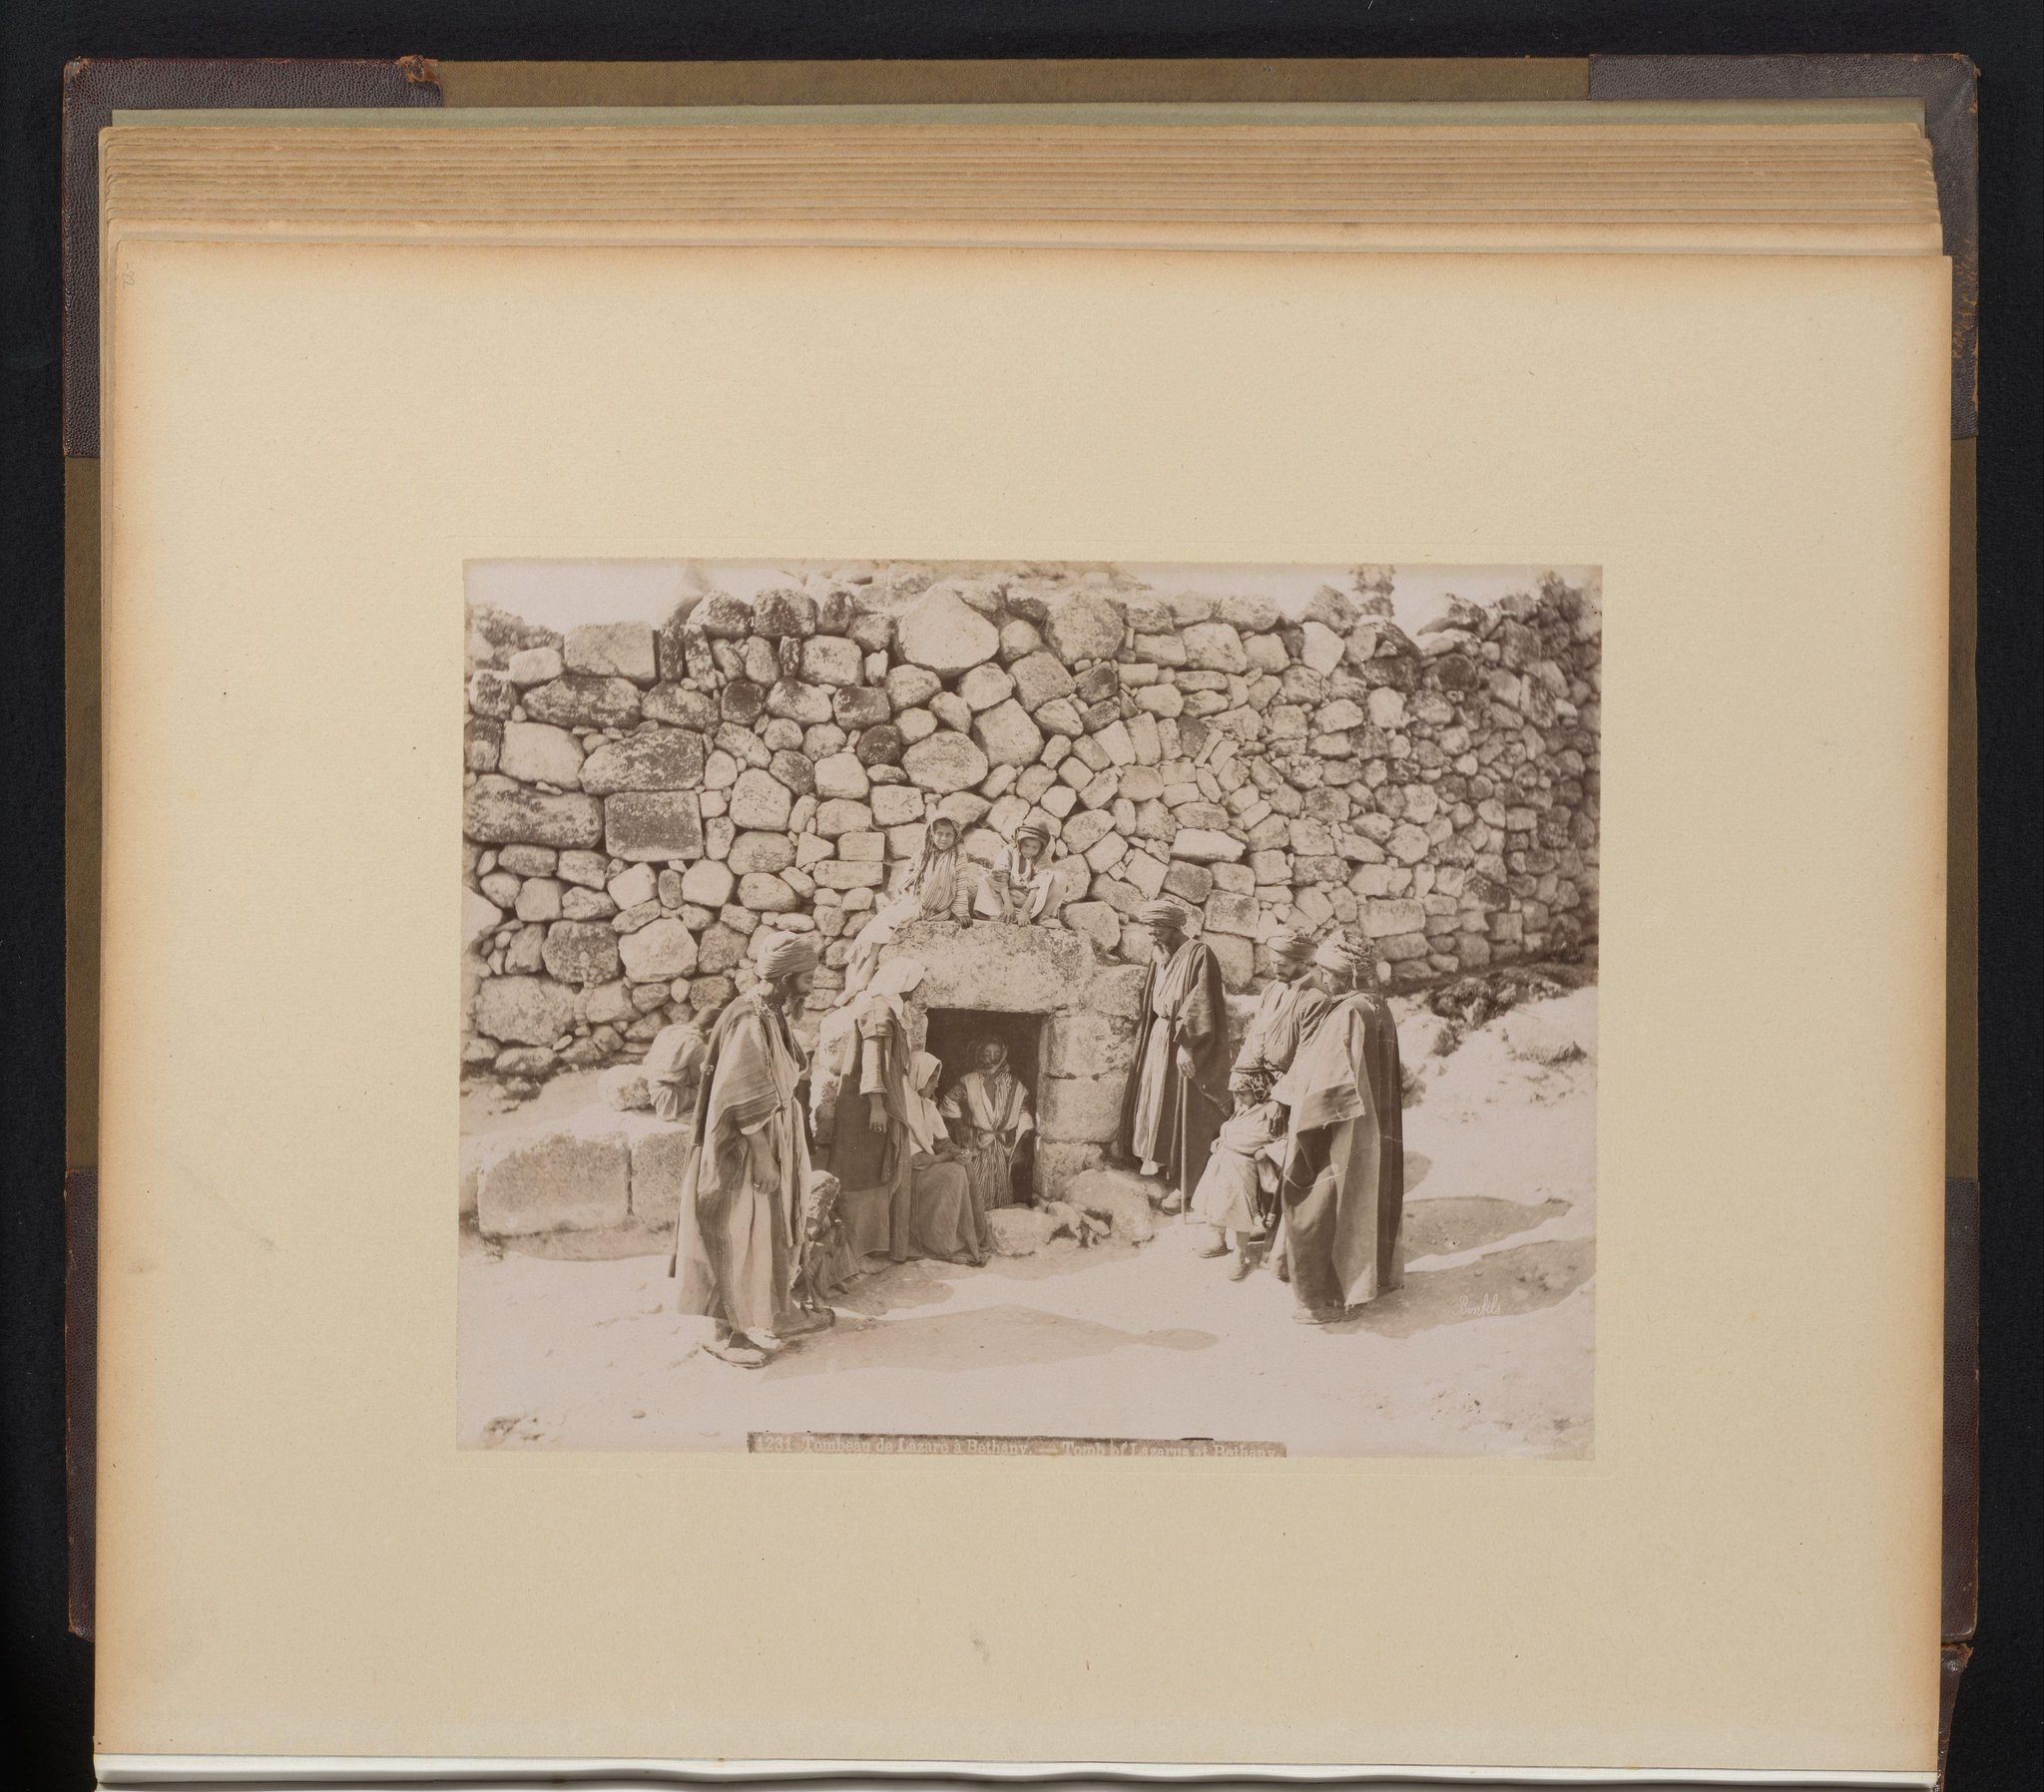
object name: photograph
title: Tombeau de Lazare à Bethany / Tomb of Lazarus at Bethany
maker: Anonymous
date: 1851-1910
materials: paper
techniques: albumen print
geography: al-eizariya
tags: grave, tomb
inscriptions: number: ‘1231’